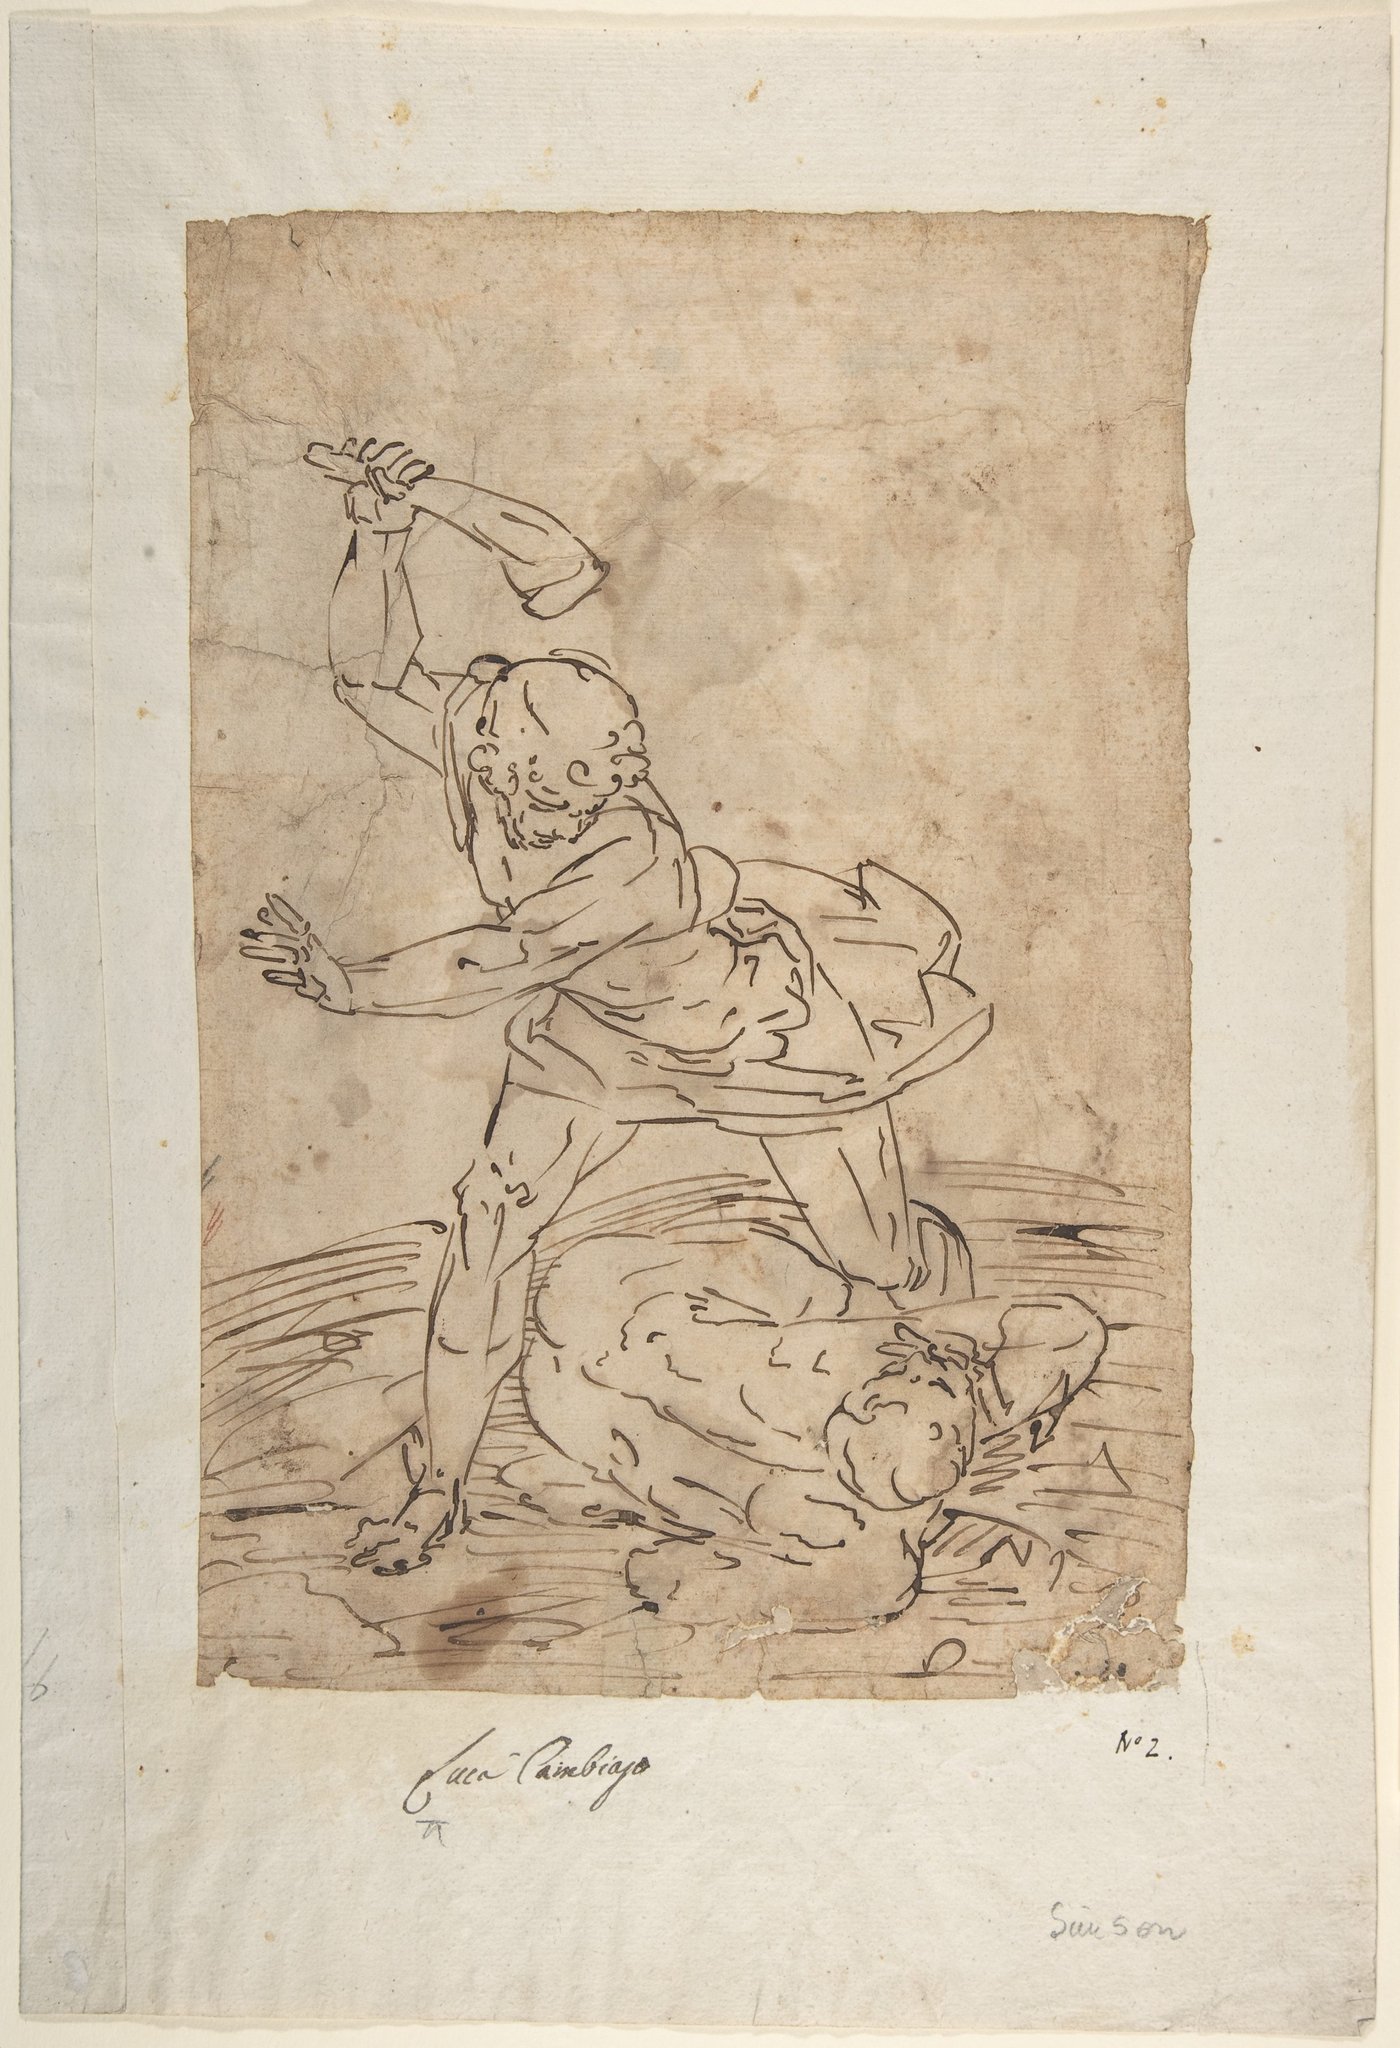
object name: drawing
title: Study of Two Male Figures Fighting.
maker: luca cambiaso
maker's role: artist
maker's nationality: italian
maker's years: 1527-1585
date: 1534-1566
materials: graphite, ink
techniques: pen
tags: men